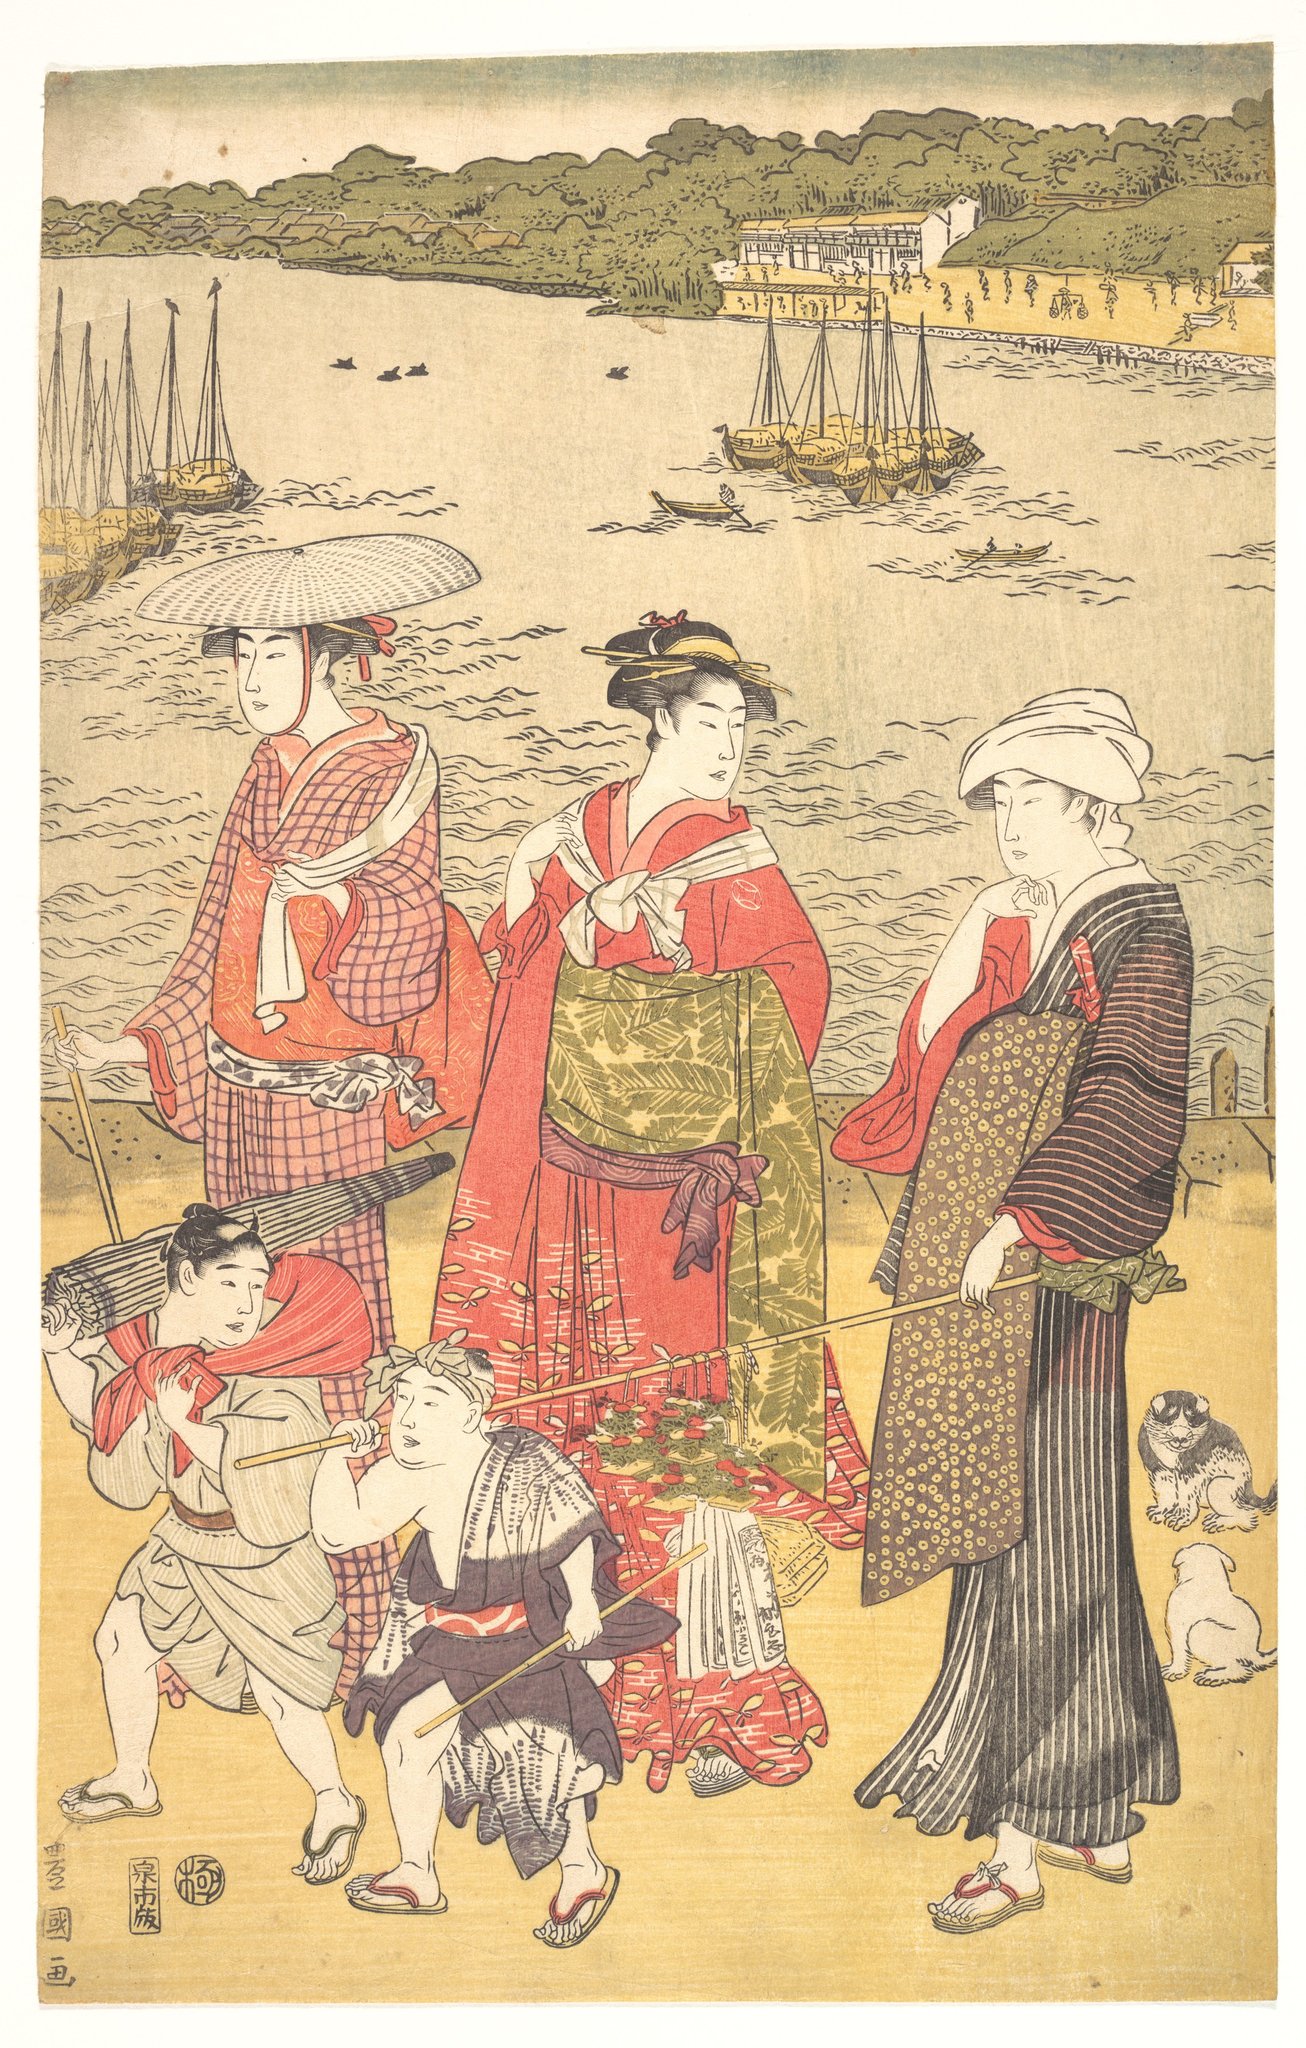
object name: print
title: Women at Takanawa Beach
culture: japanese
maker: utagawa toyokuni i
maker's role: artist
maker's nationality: japanese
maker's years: 1769-1825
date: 1790-1799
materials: ink, paper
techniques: woodblock print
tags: animals,boys,women,beaches